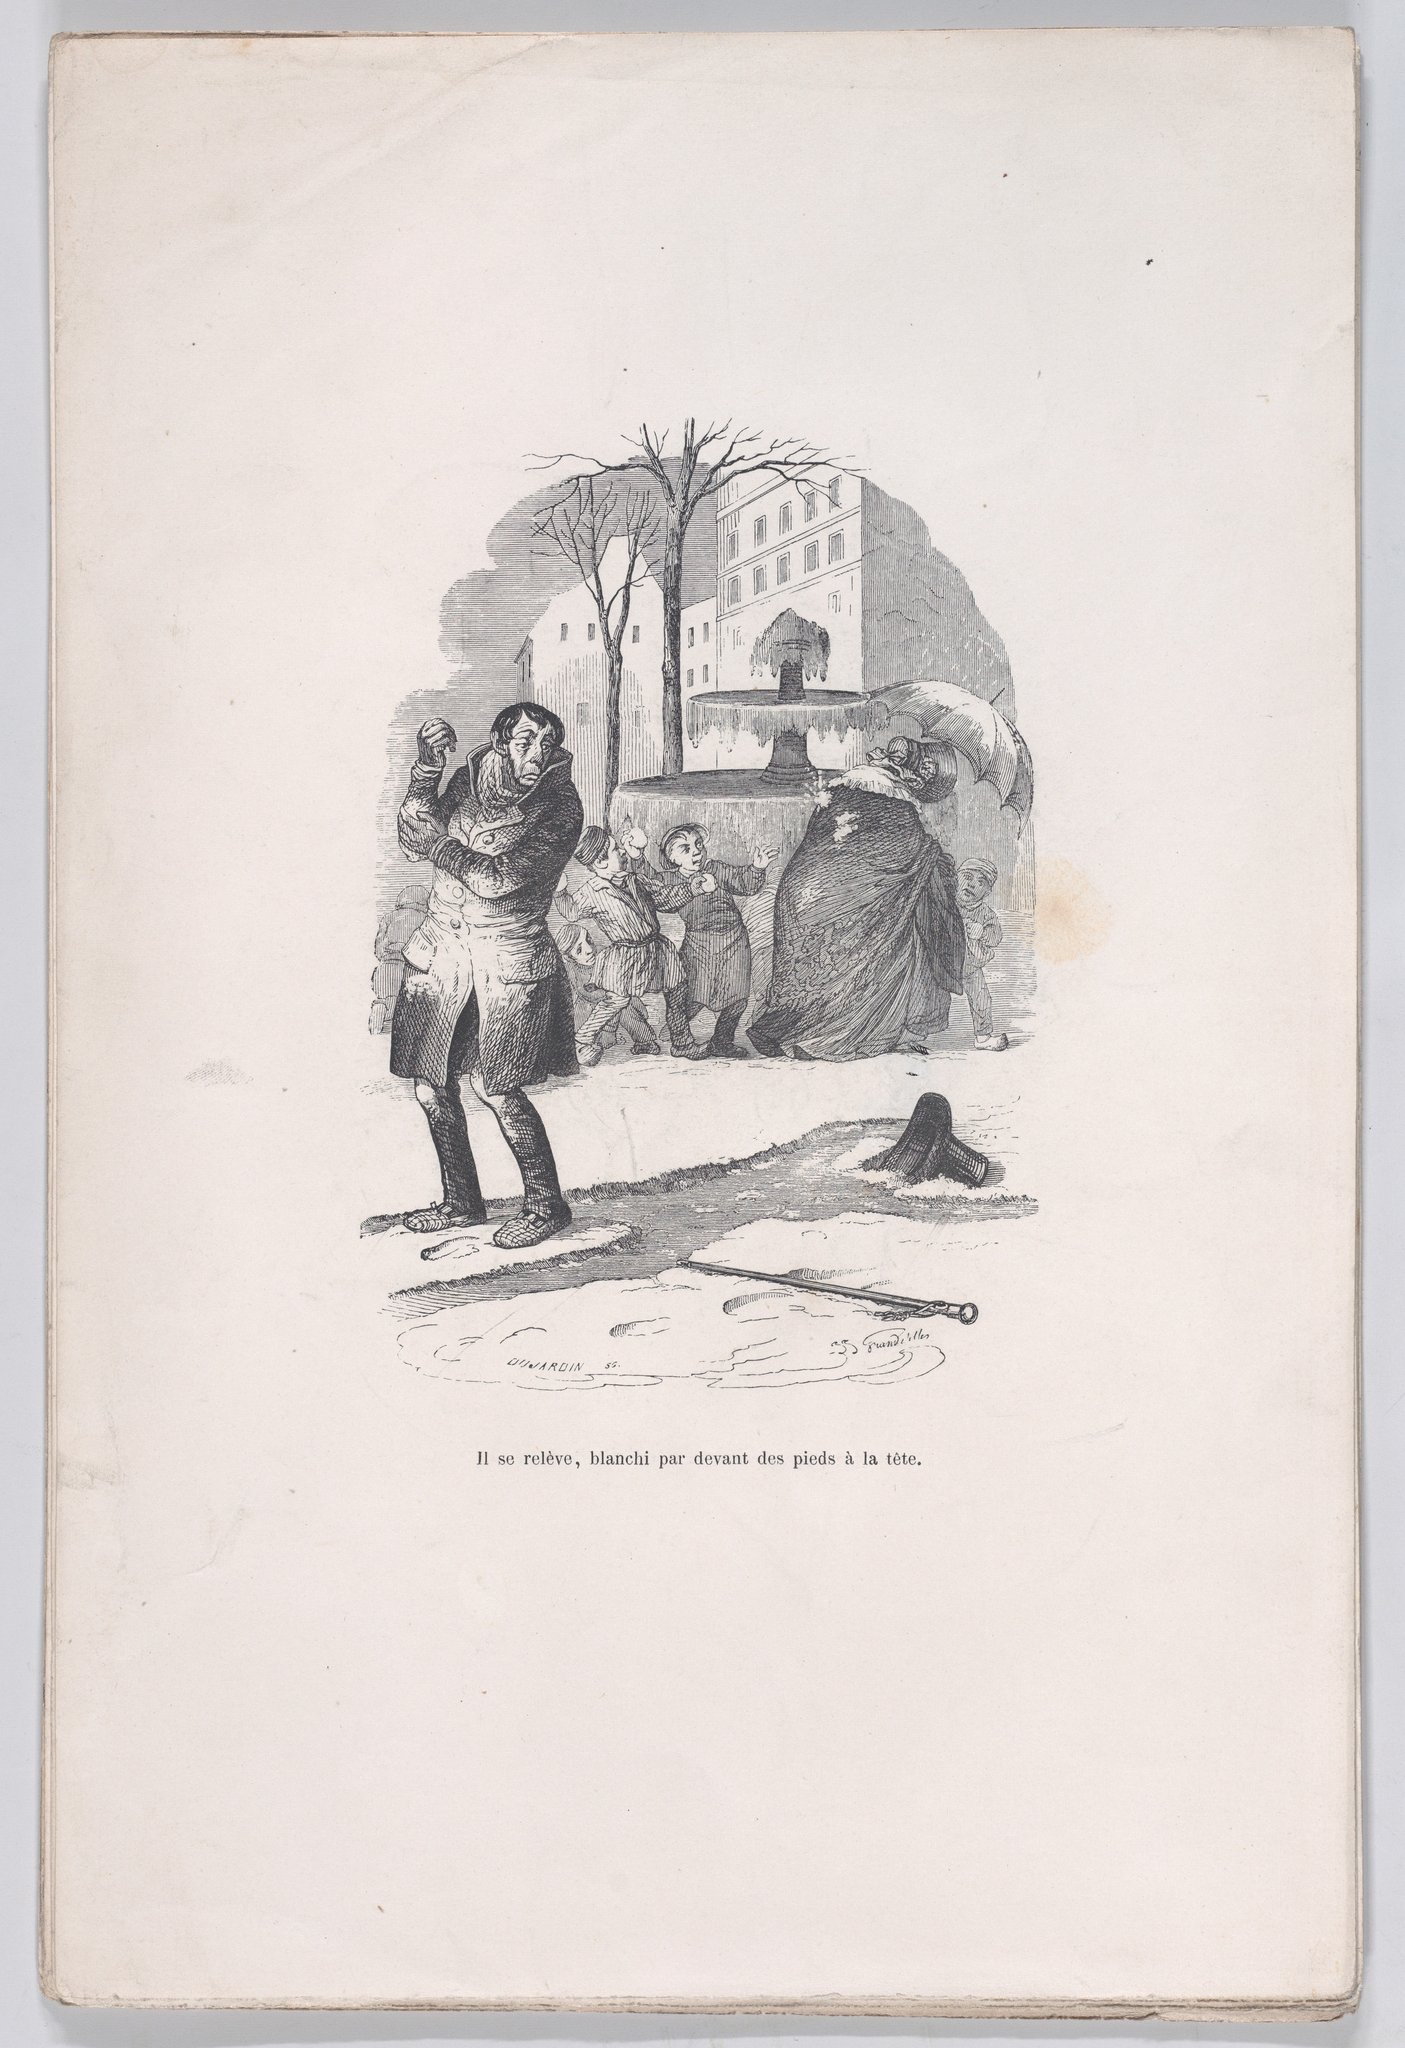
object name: print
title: He gets up, covered from head to toe in snow, from "Little Miseries of Human Life"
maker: j. j. grandville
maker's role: illustrator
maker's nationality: french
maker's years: 1803-1847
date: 1843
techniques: engraving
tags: children,men,women,snow